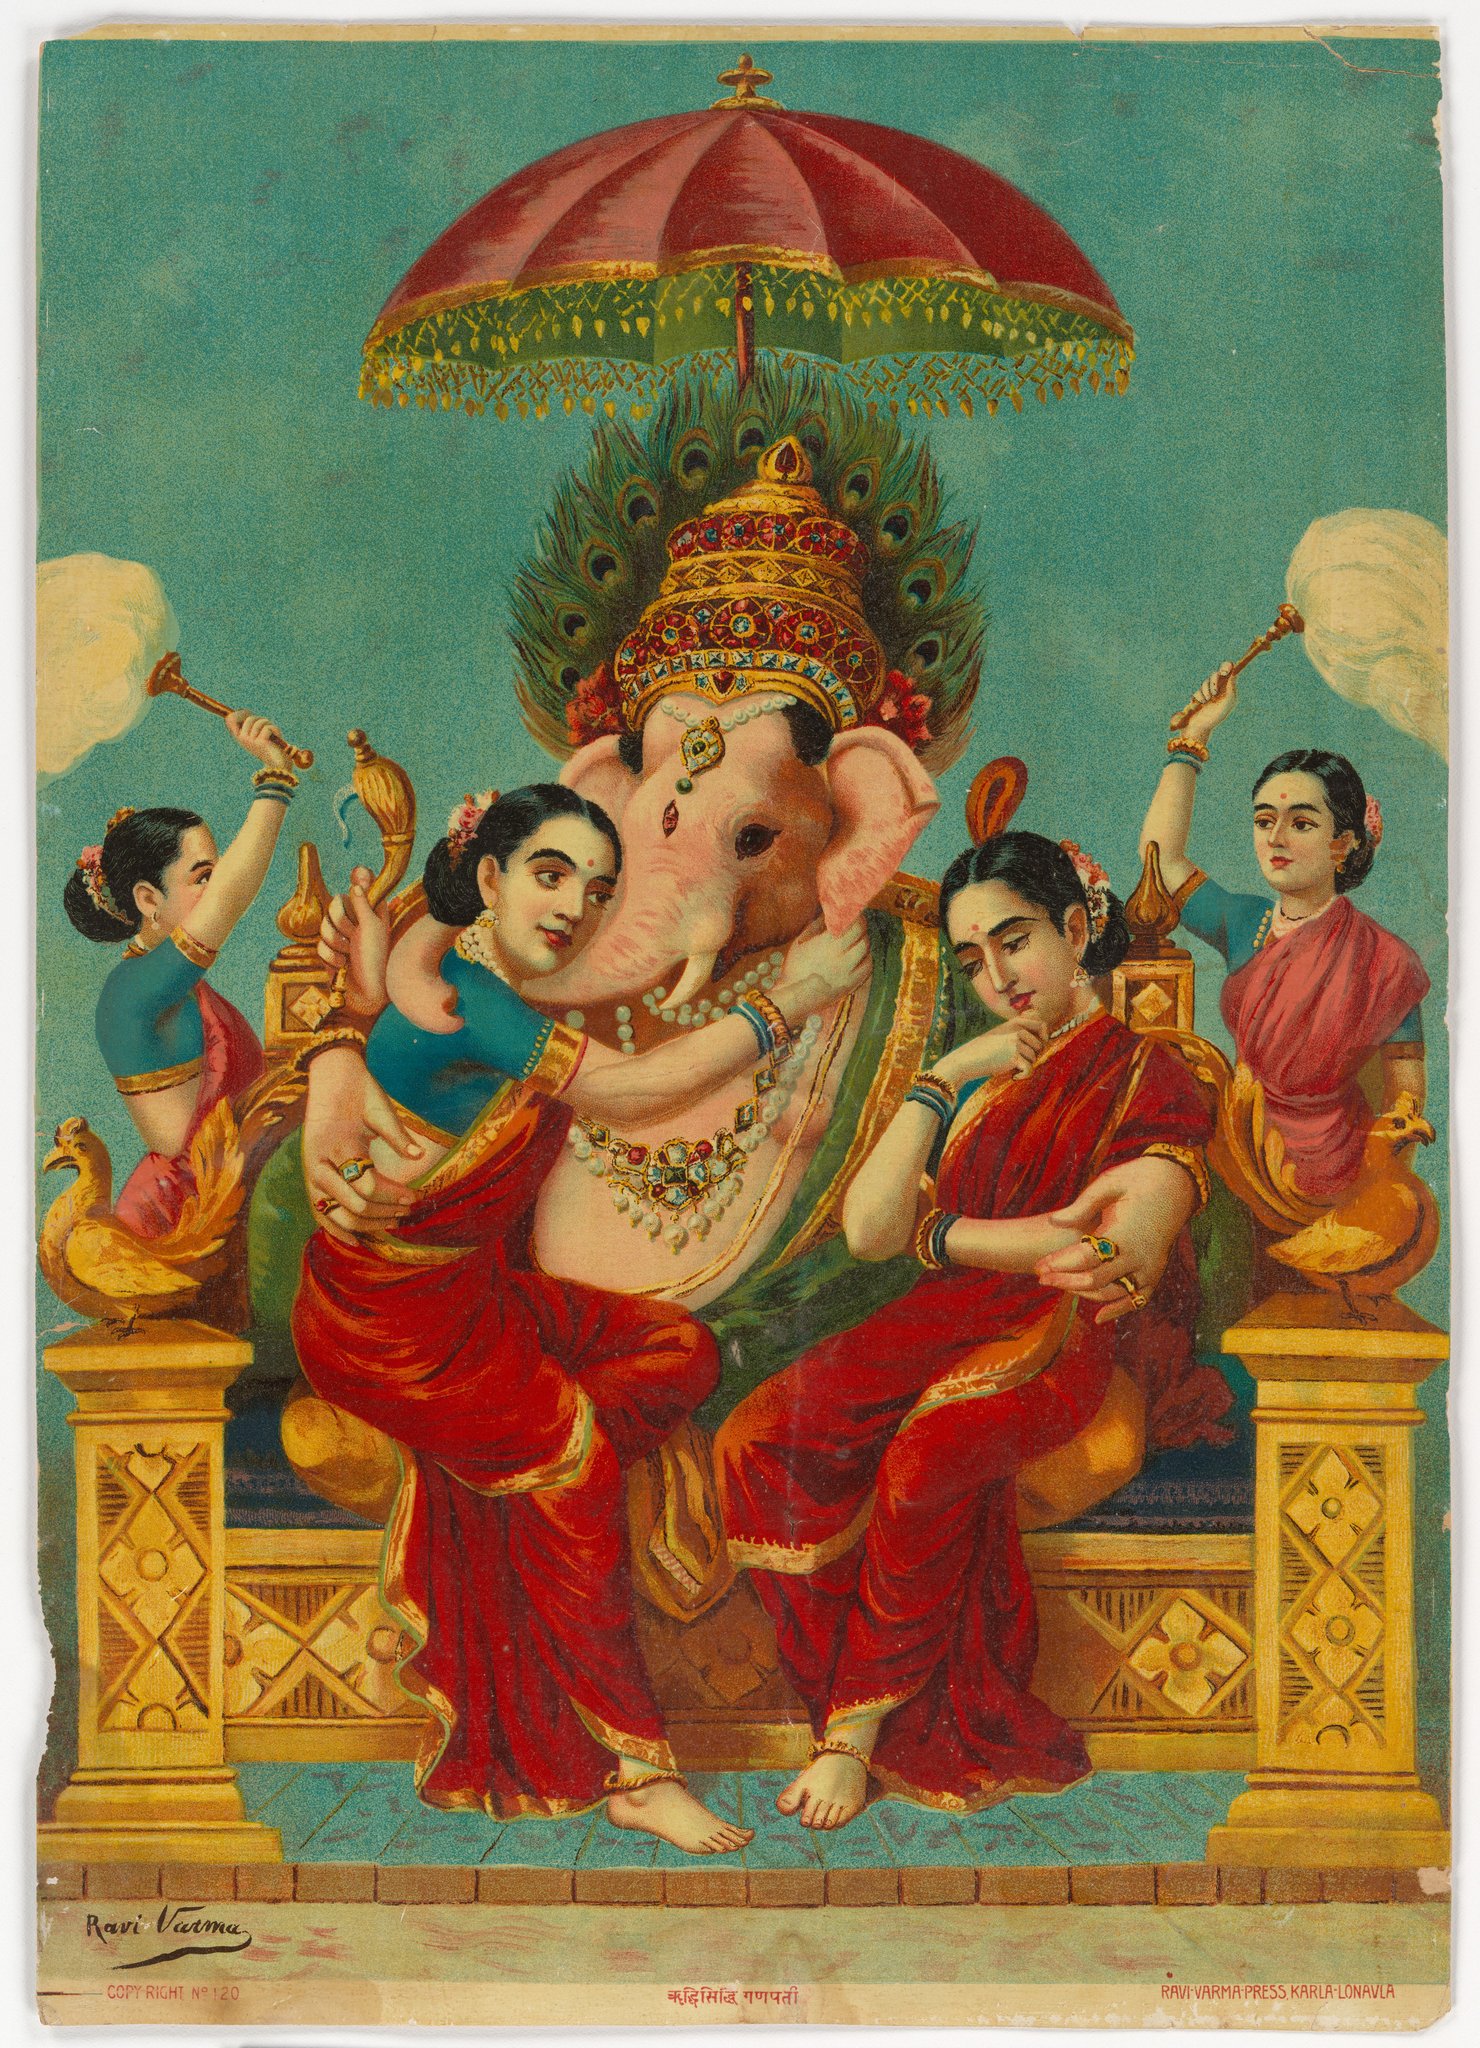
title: Ganapati with his consorts Riddhi and Siddhi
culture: indian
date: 1900-1915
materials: varnish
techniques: lithograph